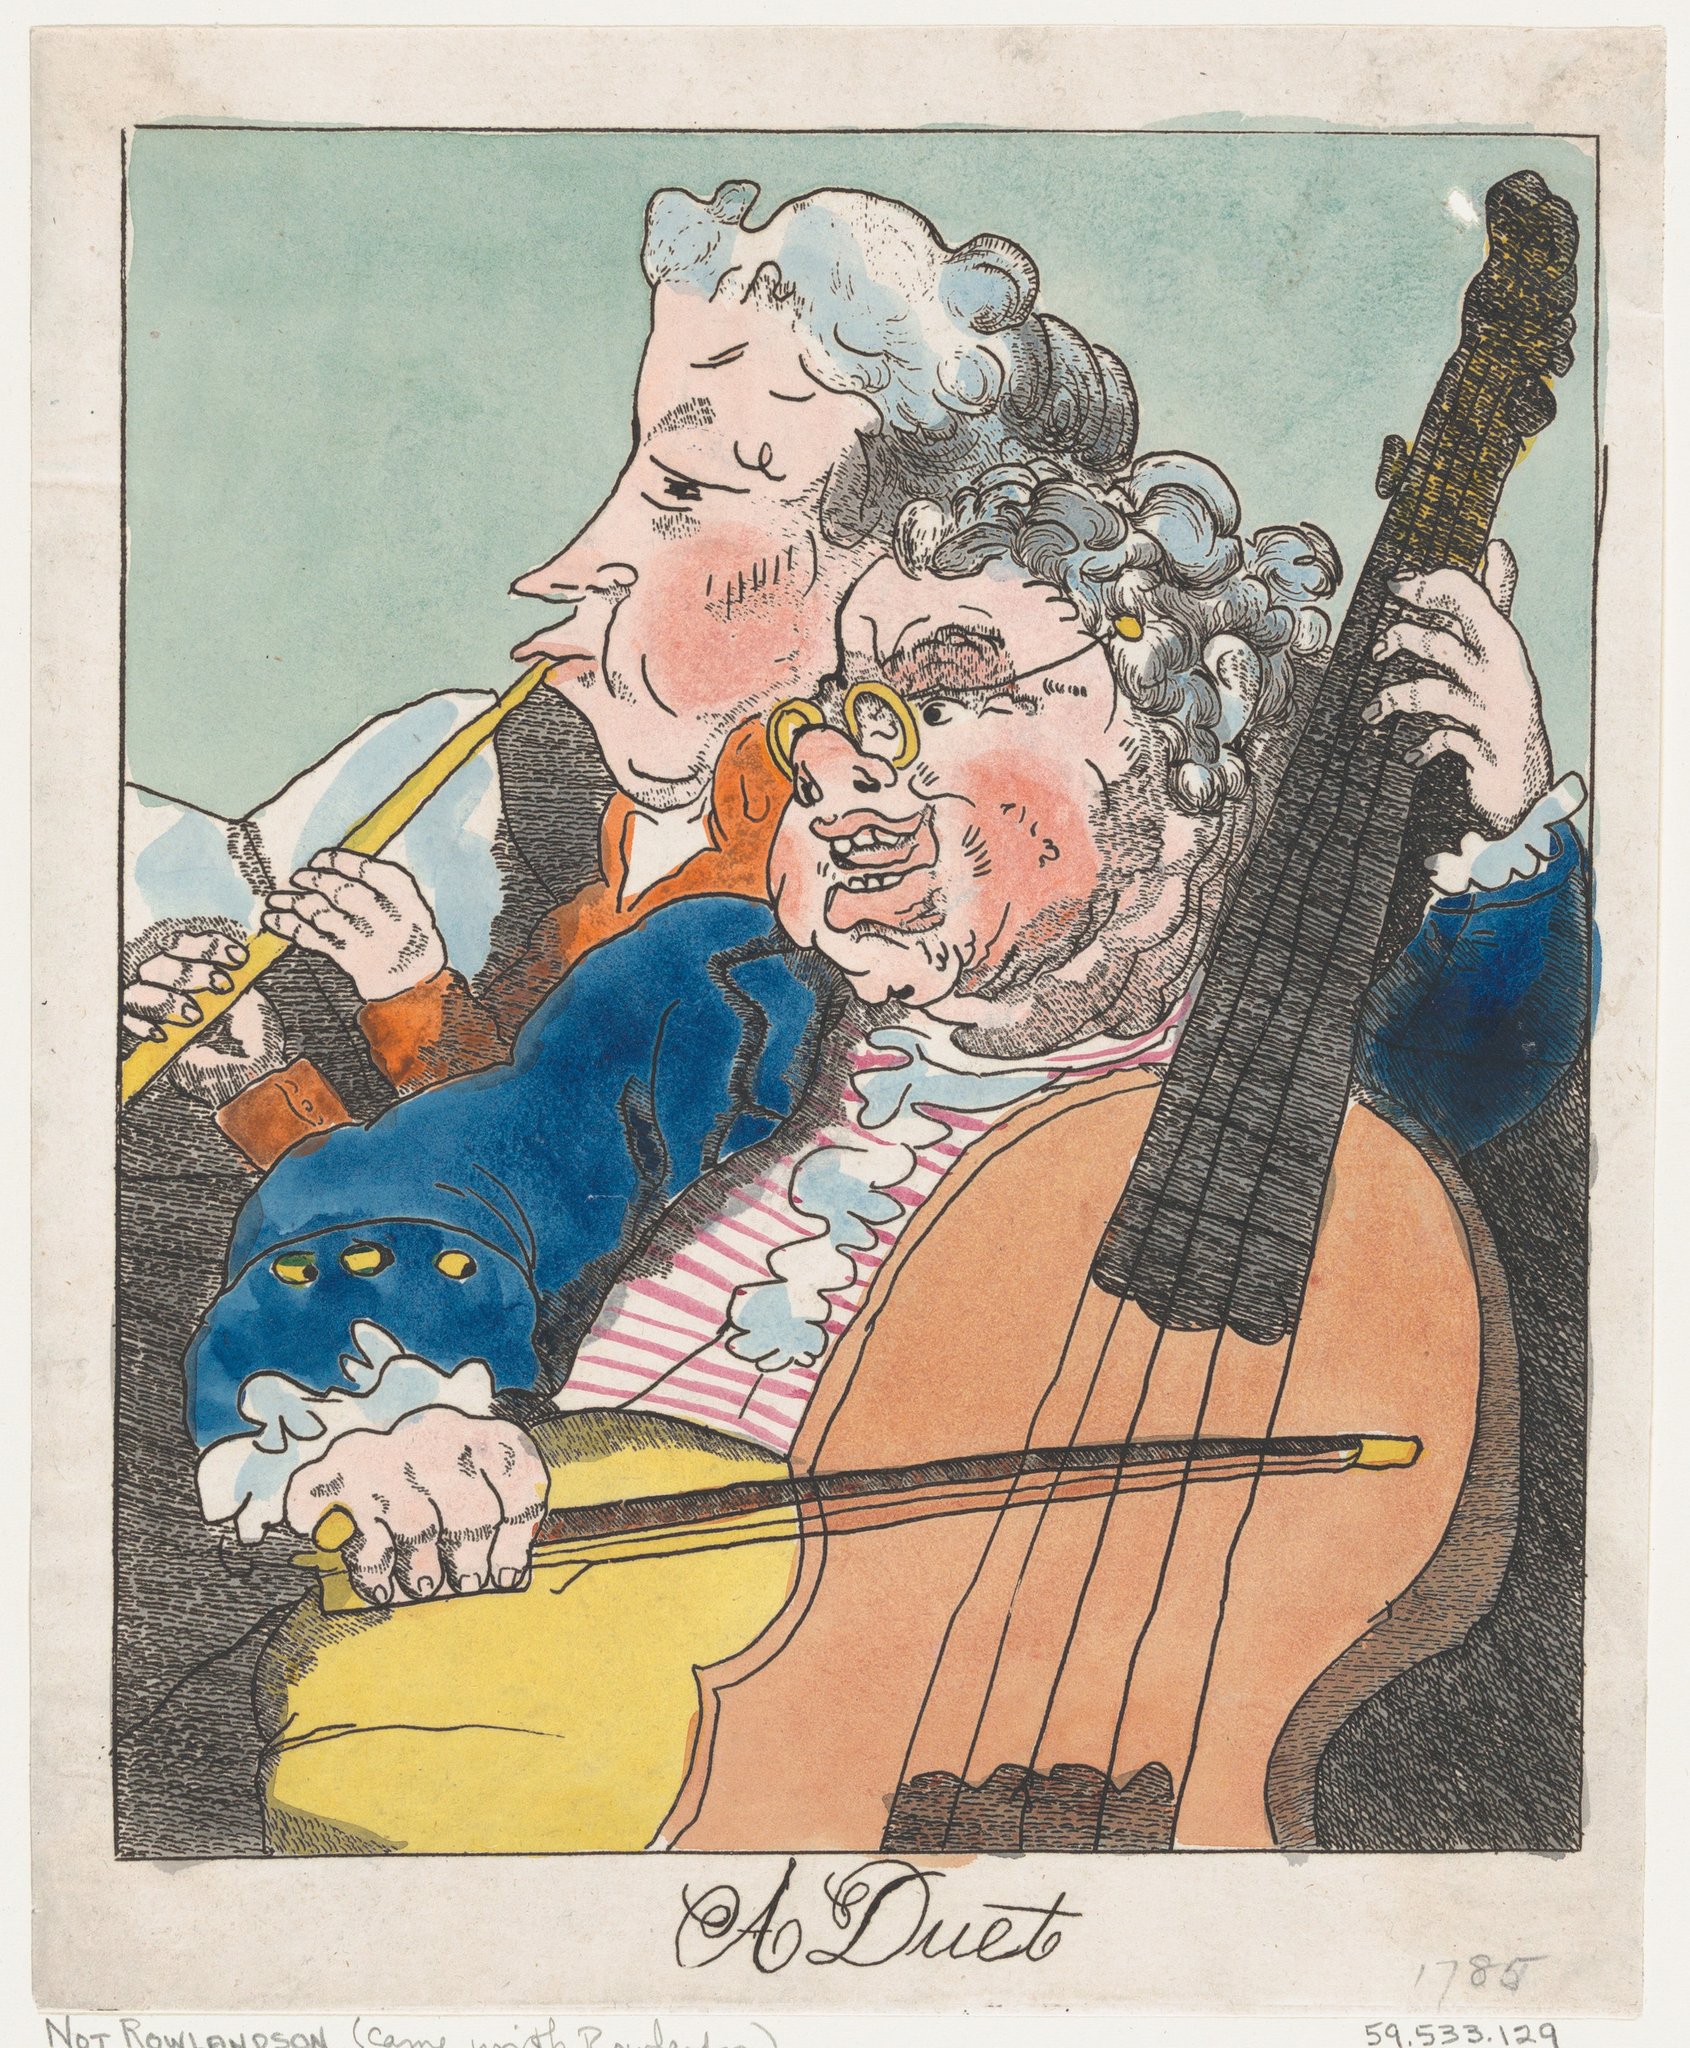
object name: print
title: A Duet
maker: anonymous, british, late 18th–early 19th century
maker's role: etcher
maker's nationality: british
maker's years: 1771-1835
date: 1785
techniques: etching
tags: musical instruments,men,musicians,caricature